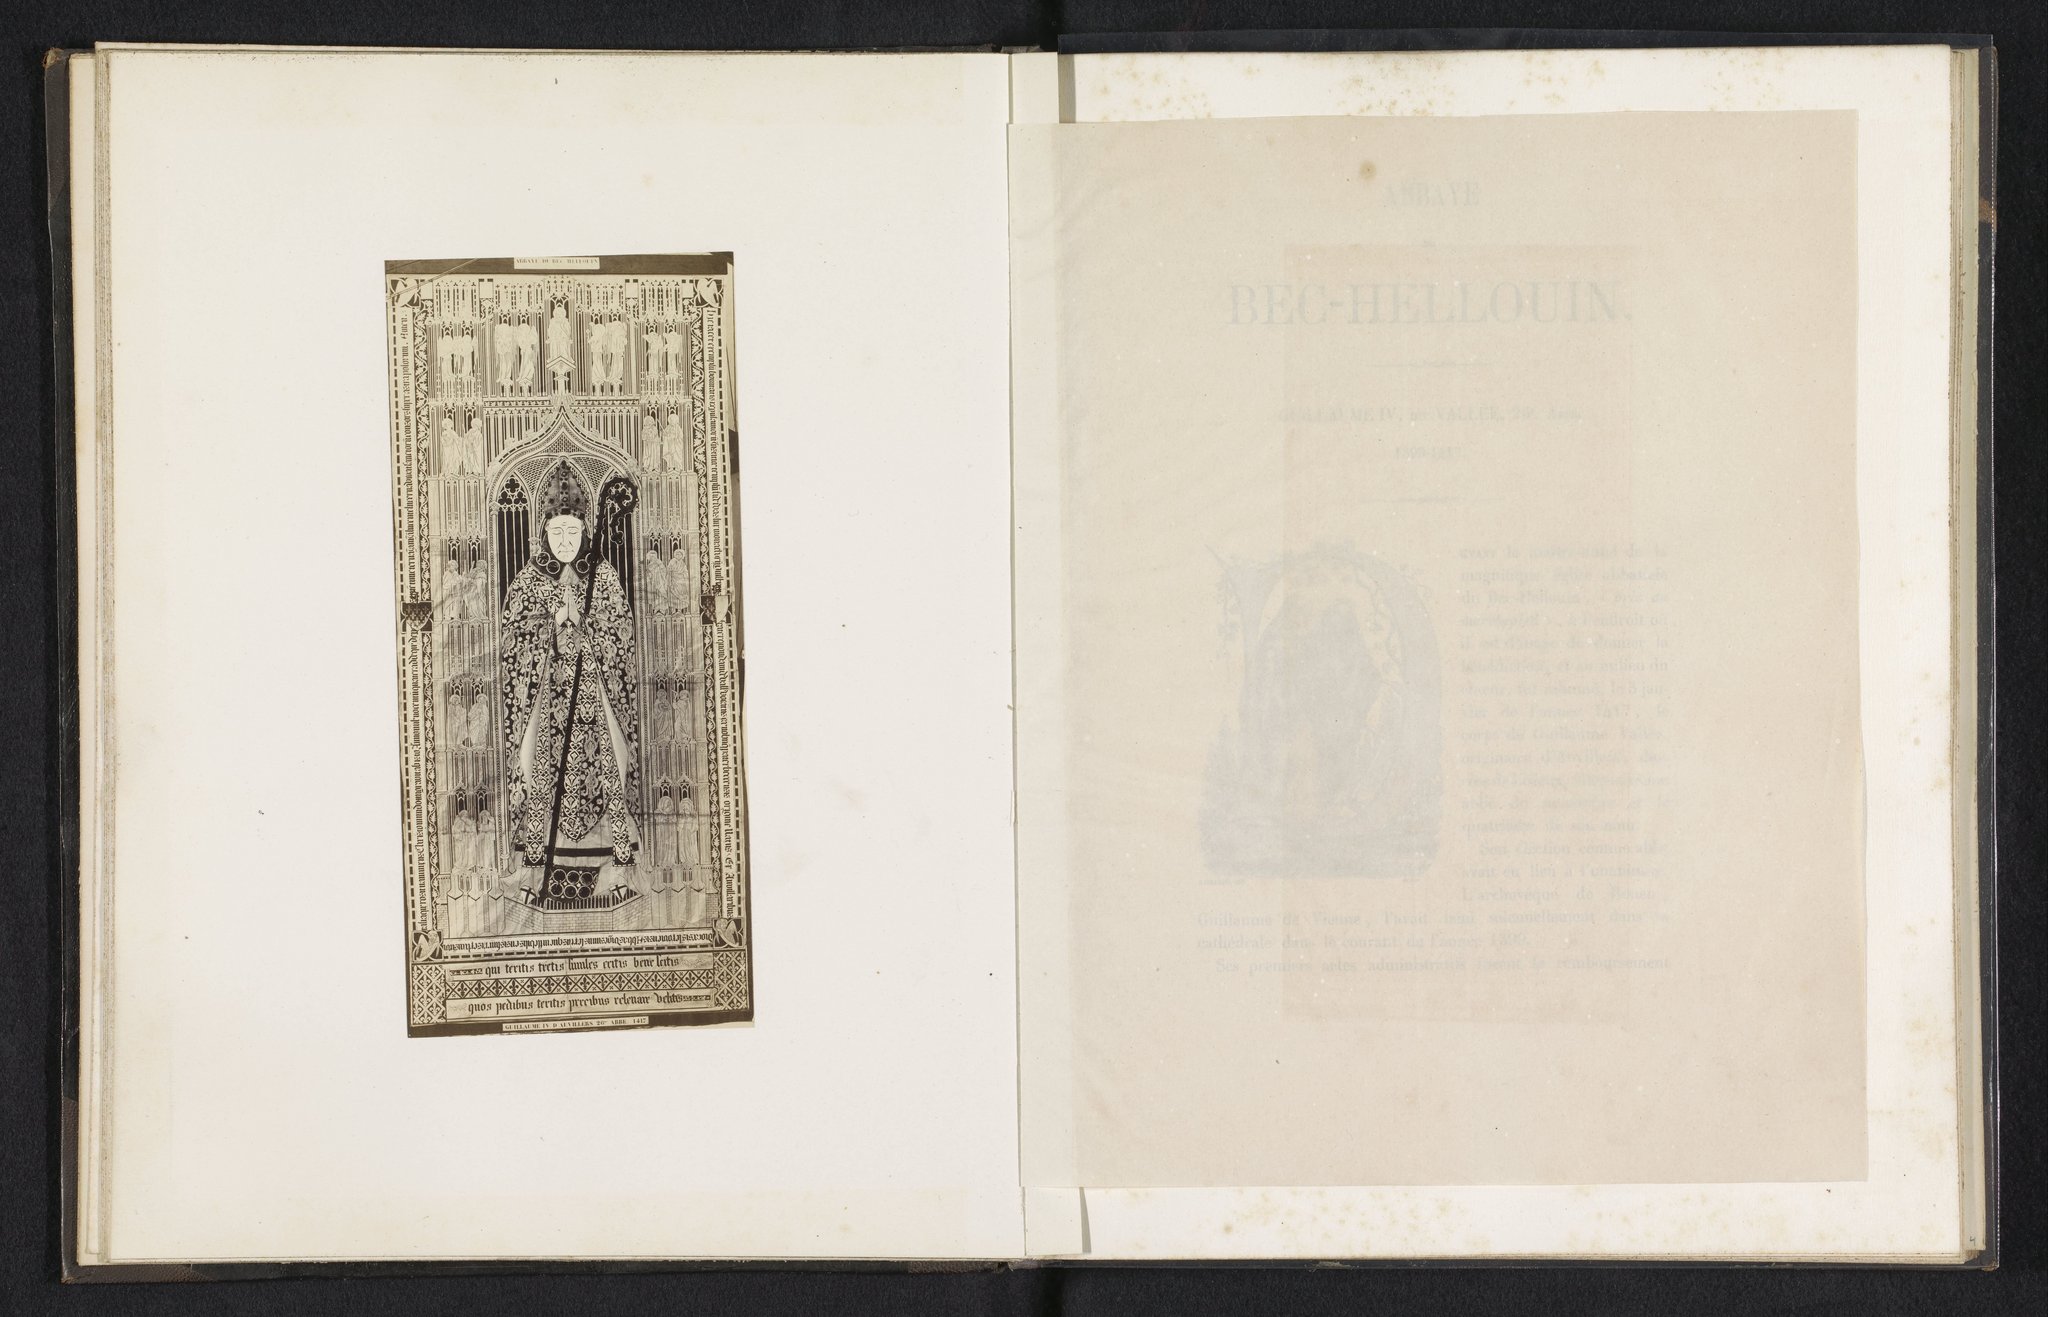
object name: photograph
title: Fotoreproductie van een stempel naar een grafsteen van Guillaume IV d’Auvillars in de Abdij van Bec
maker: Anonymous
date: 1851-1861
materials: photographic support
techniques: albumen print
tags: abbot, gravestone, tombstone